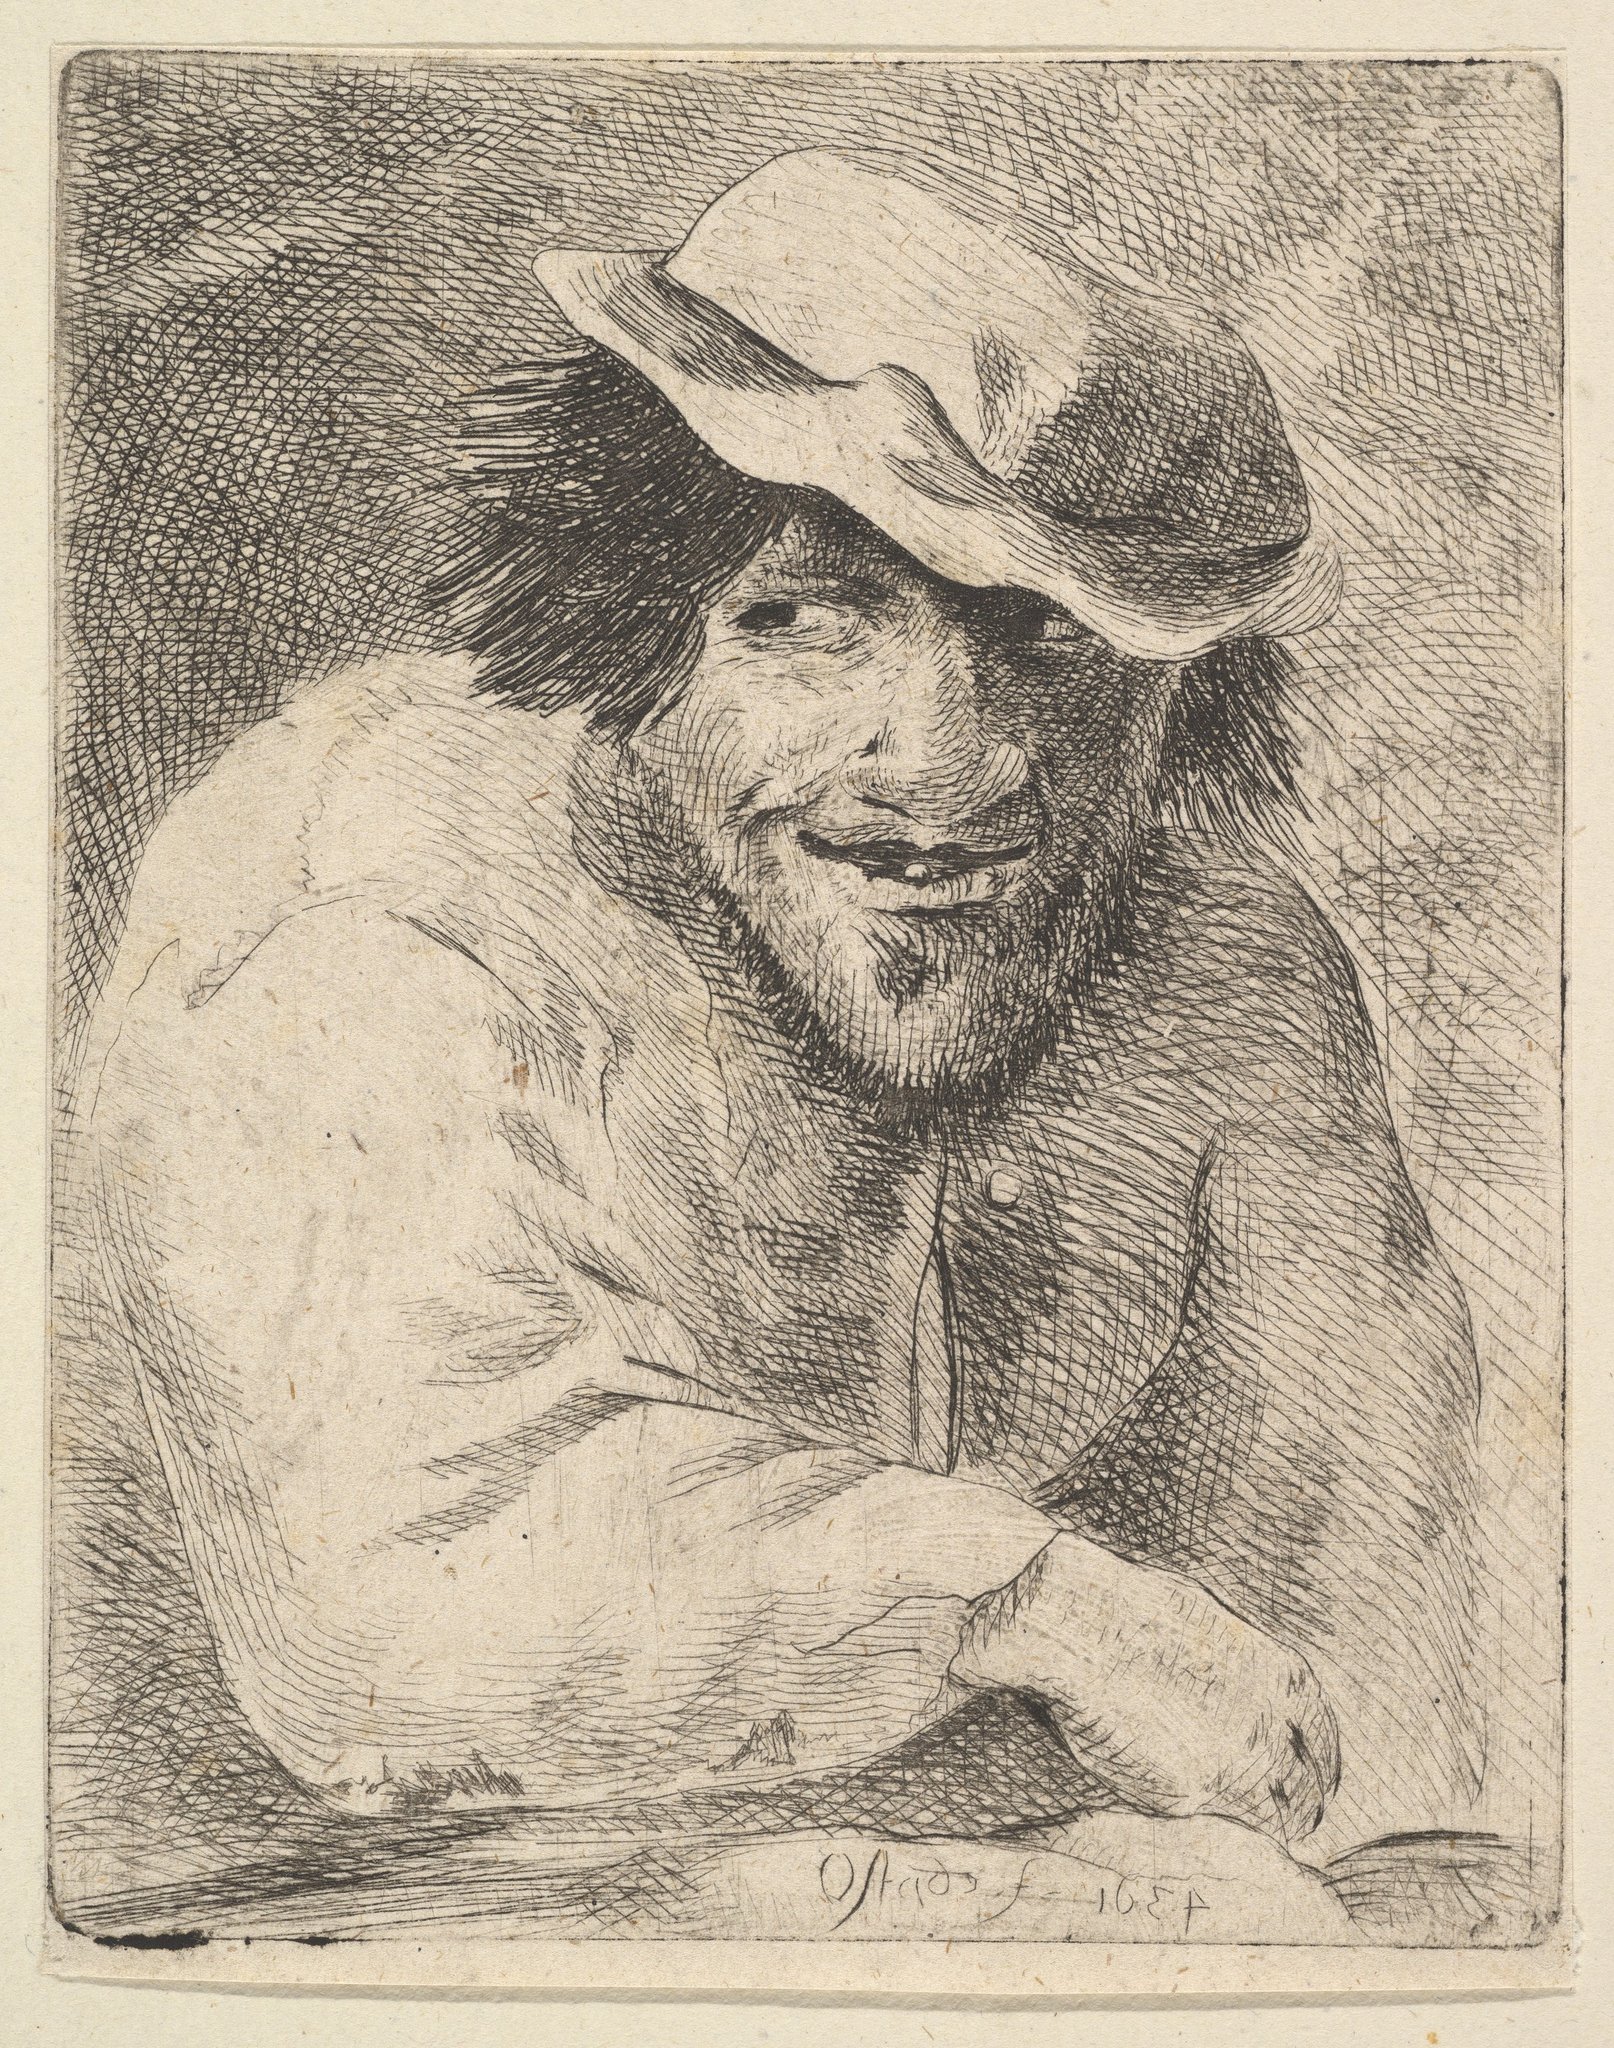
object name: print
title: Man Leering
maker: adriaen van ostade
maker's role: artist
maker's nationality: dutch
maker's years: 1610-1685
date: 1610-1685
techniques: etching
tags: men,portraits